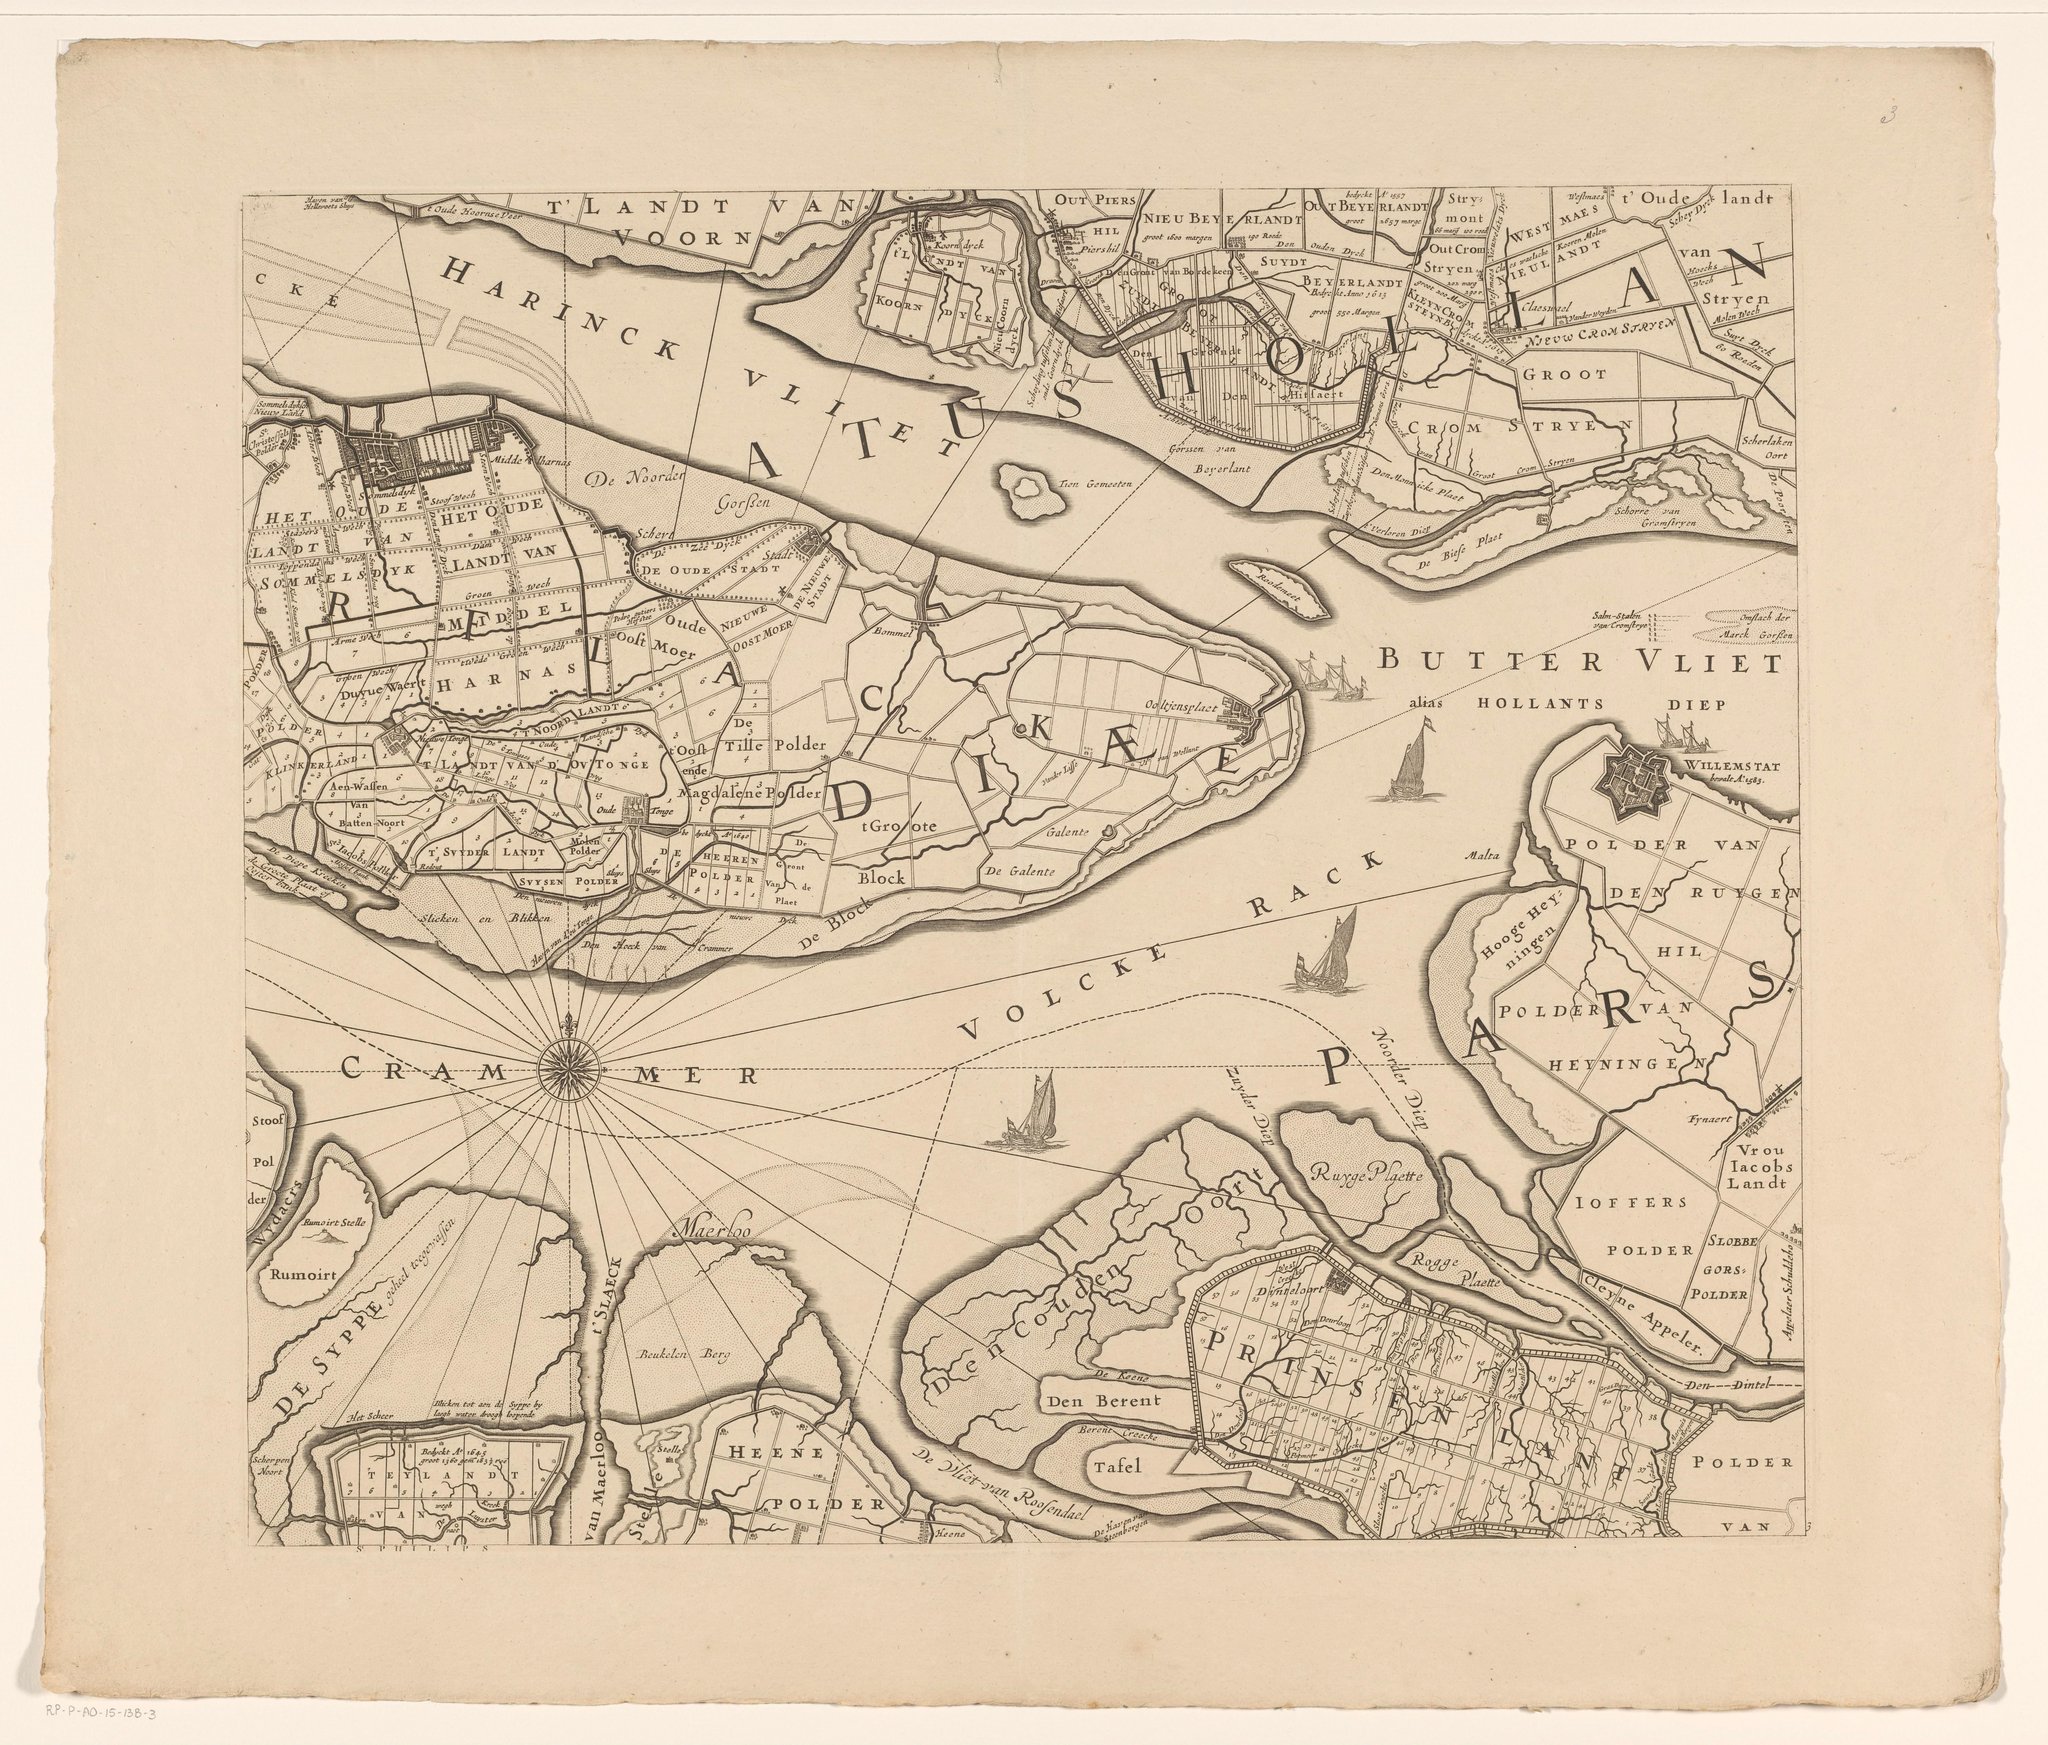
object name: print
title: Zelandiae Comitatus novissima tabula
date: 1655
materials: paper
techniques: engraving, etching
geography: amsterdam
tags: maps of separate countries or regions, zeeland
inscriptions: collector's mark: Lugt 19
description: Derde deel van een kaart van Zeeland, bestaande uit negen delen. Rechtsonder genummerd: 3.